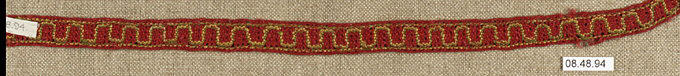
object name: insertion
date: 1801-1900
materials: silk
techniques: lace